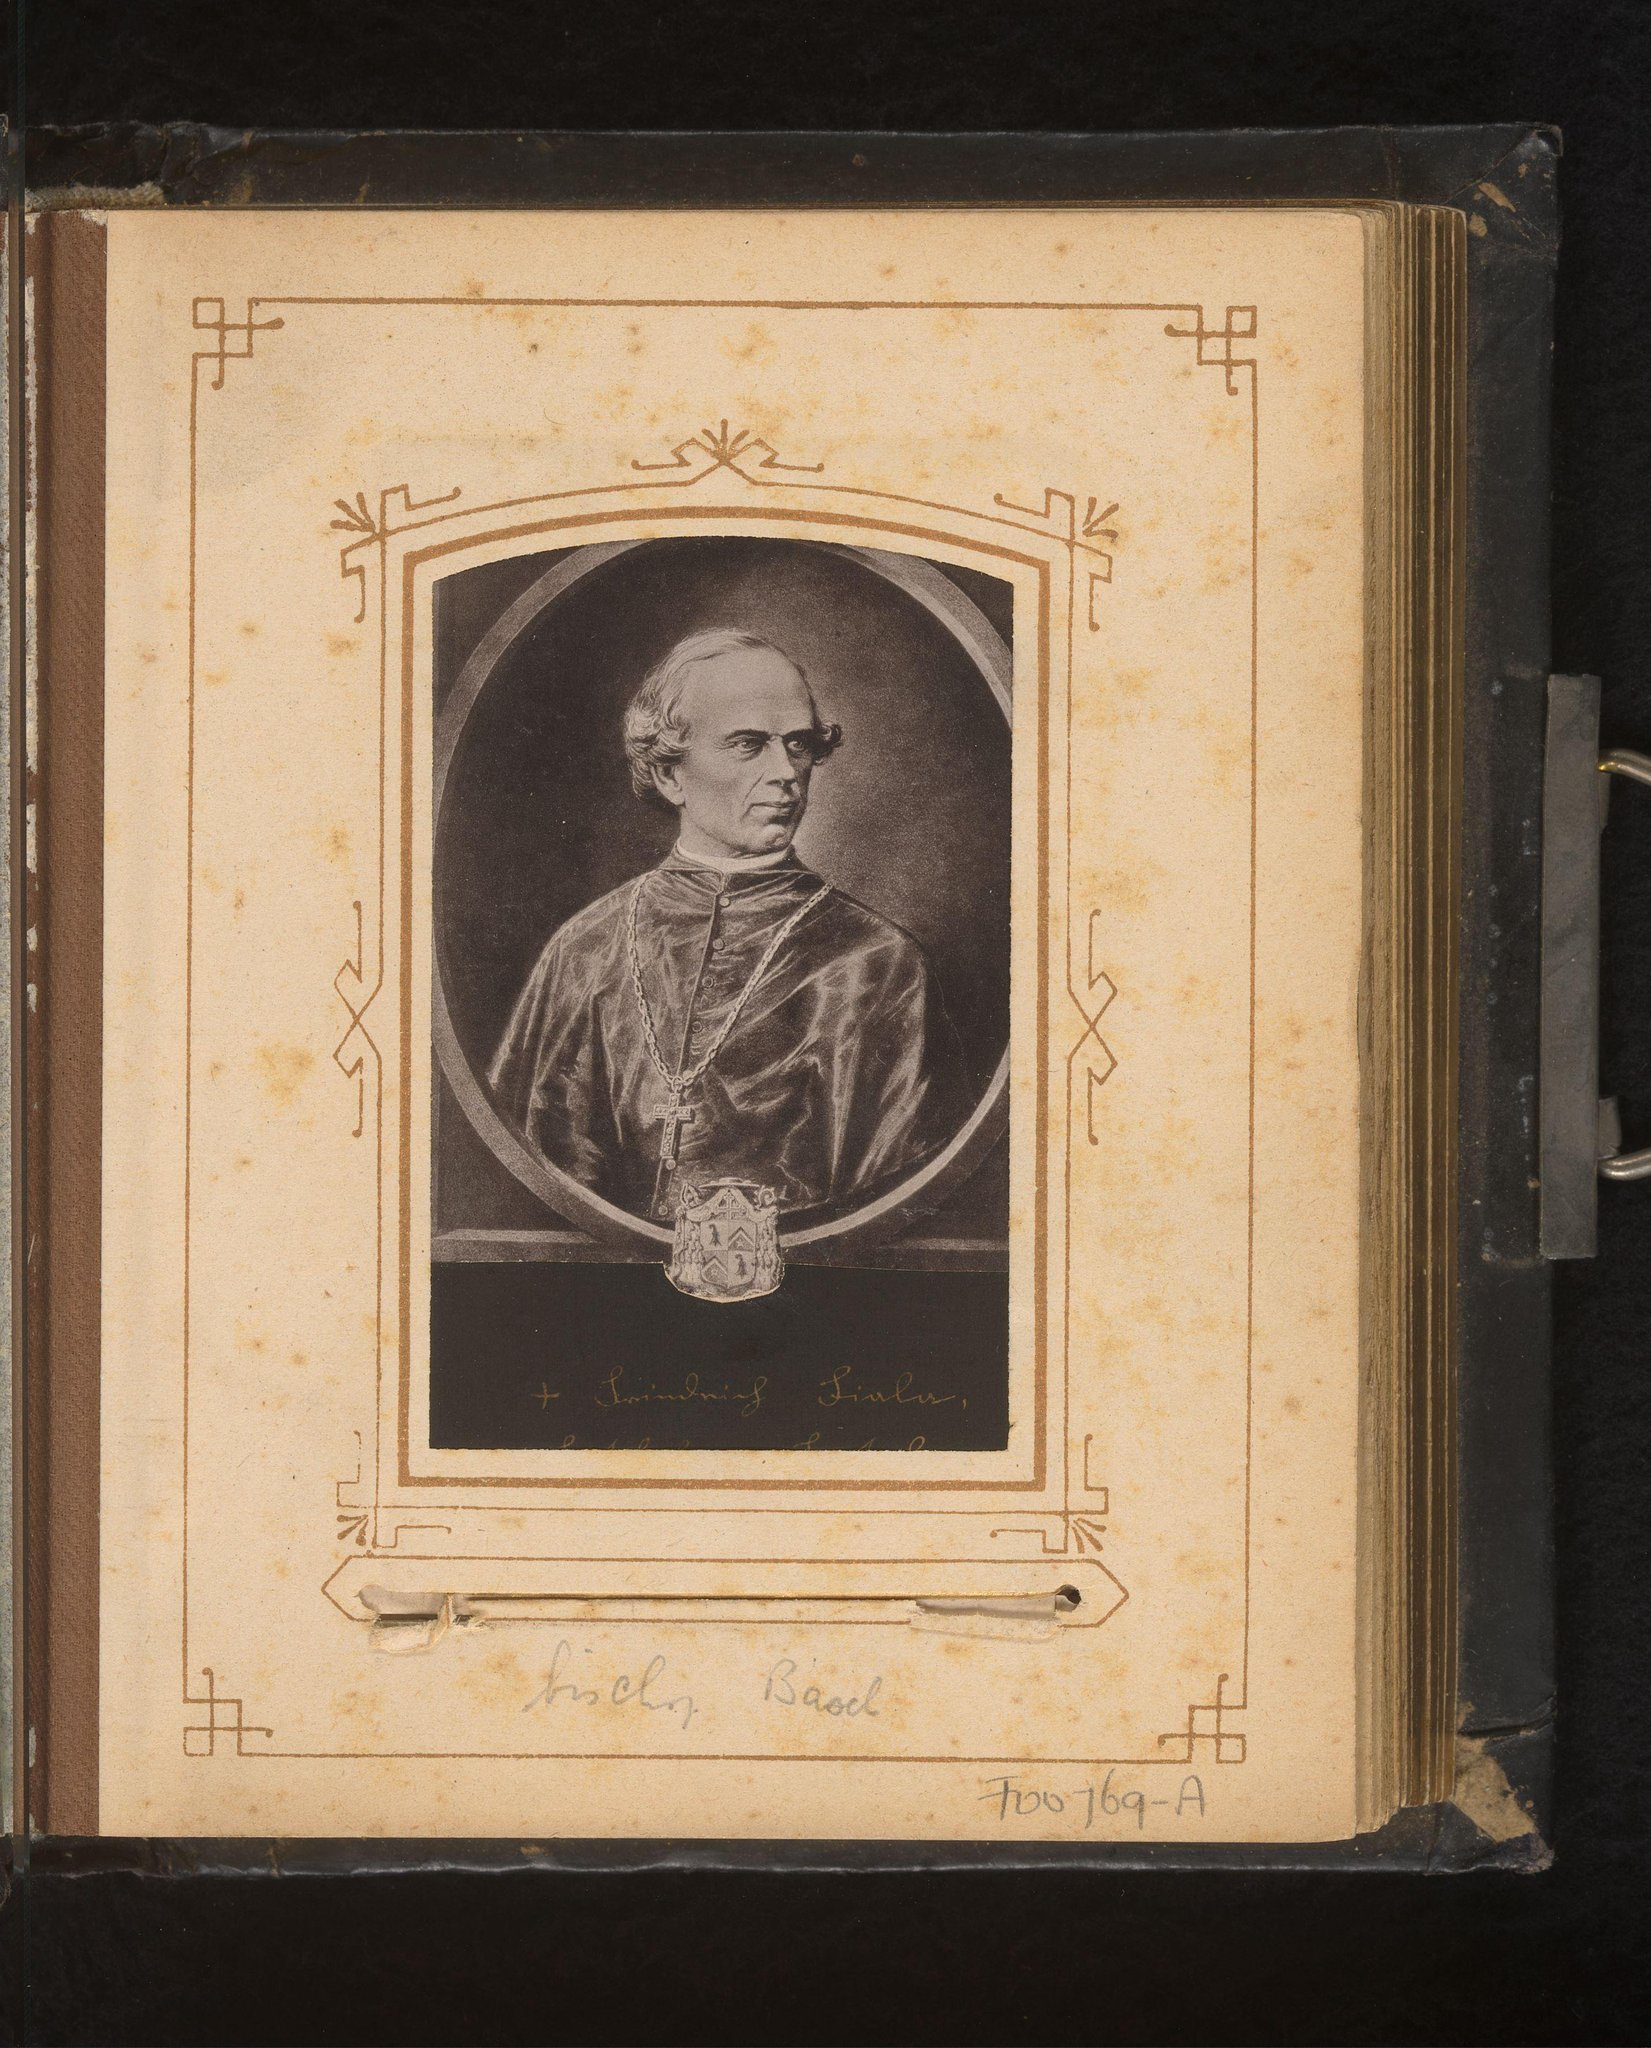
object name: album leaf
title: Reproductie van een portret van de bisschop van Bazel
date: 1865-1900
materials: cardboard, paper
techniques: photograph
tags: adult man, organization, functionaries and dignitaries in roman catholic church; clergy in general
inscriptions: inscription: ‘[...]/ Kunst Verlag B. Schwendimann, Solothurn (Schweiz)/ (...)’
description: Deze fotomechanische afdruk maakt deel uit van een album.